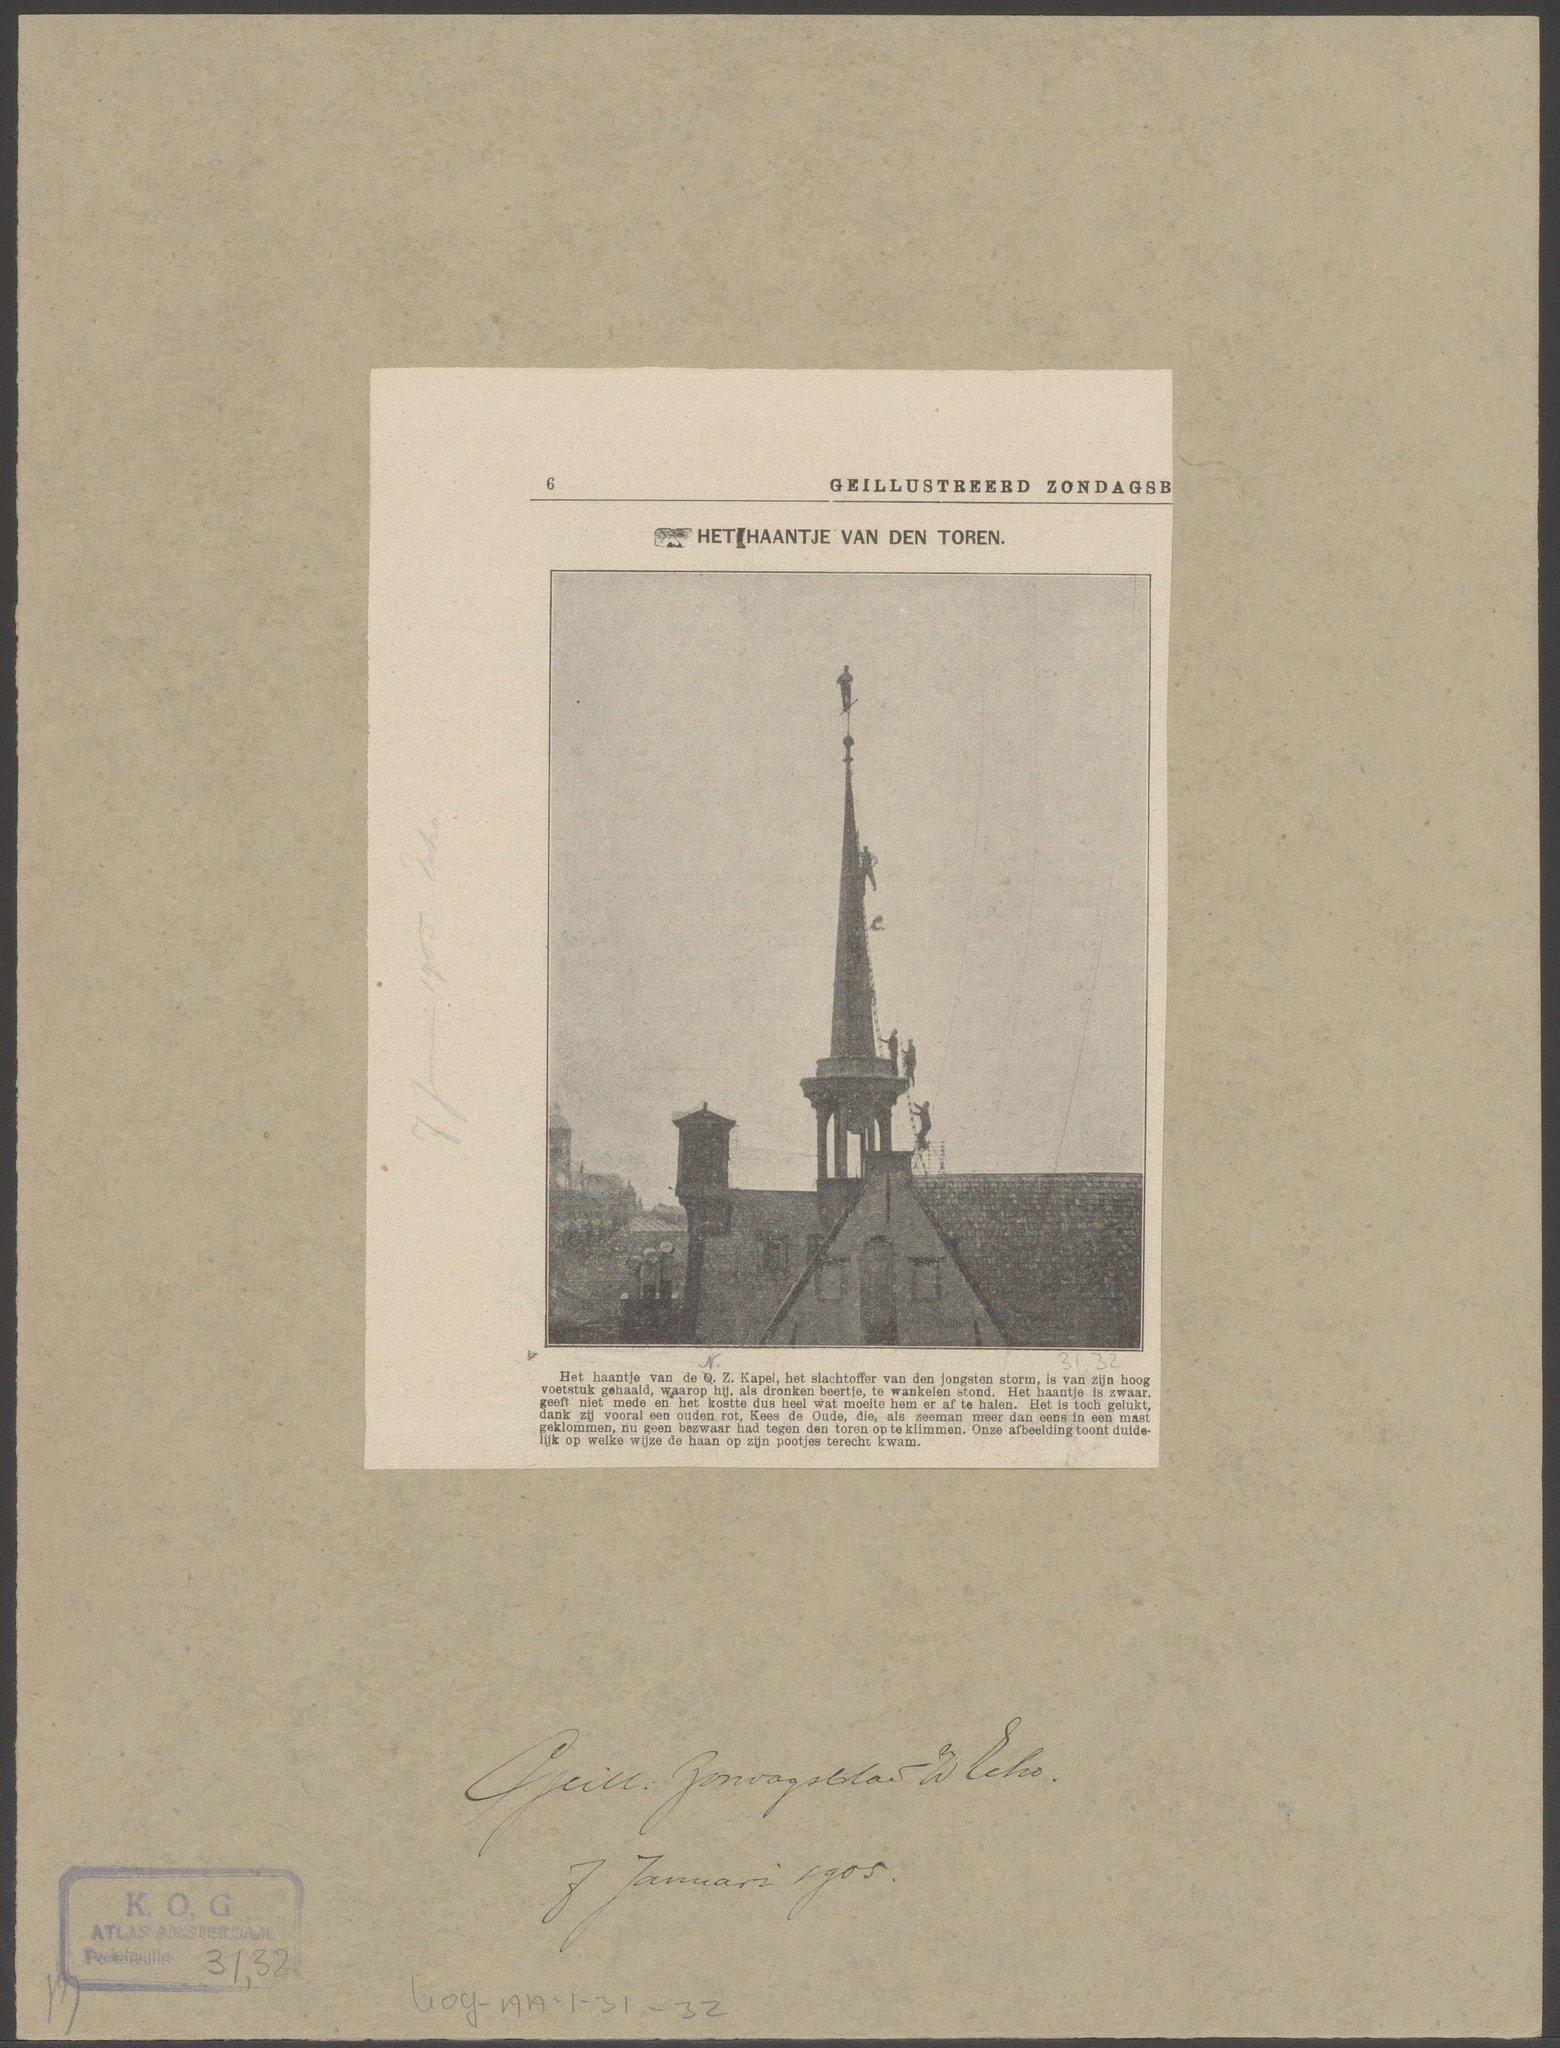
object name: photomechanical print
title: Het haantje van den toren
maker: Anonymous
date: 1905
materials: paper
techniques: letterpress printing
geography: netherlands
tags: weathercock, climbing, parts of church exterior and annexes: tower - qq - small church, chapel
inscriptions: collector's mark: Lugt 1641b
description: Onderwerpsrubriek binnen de Atlas Amsterdam: Kerkwezen: Hervormde Gemeente: Nieuwezijds Kapel.